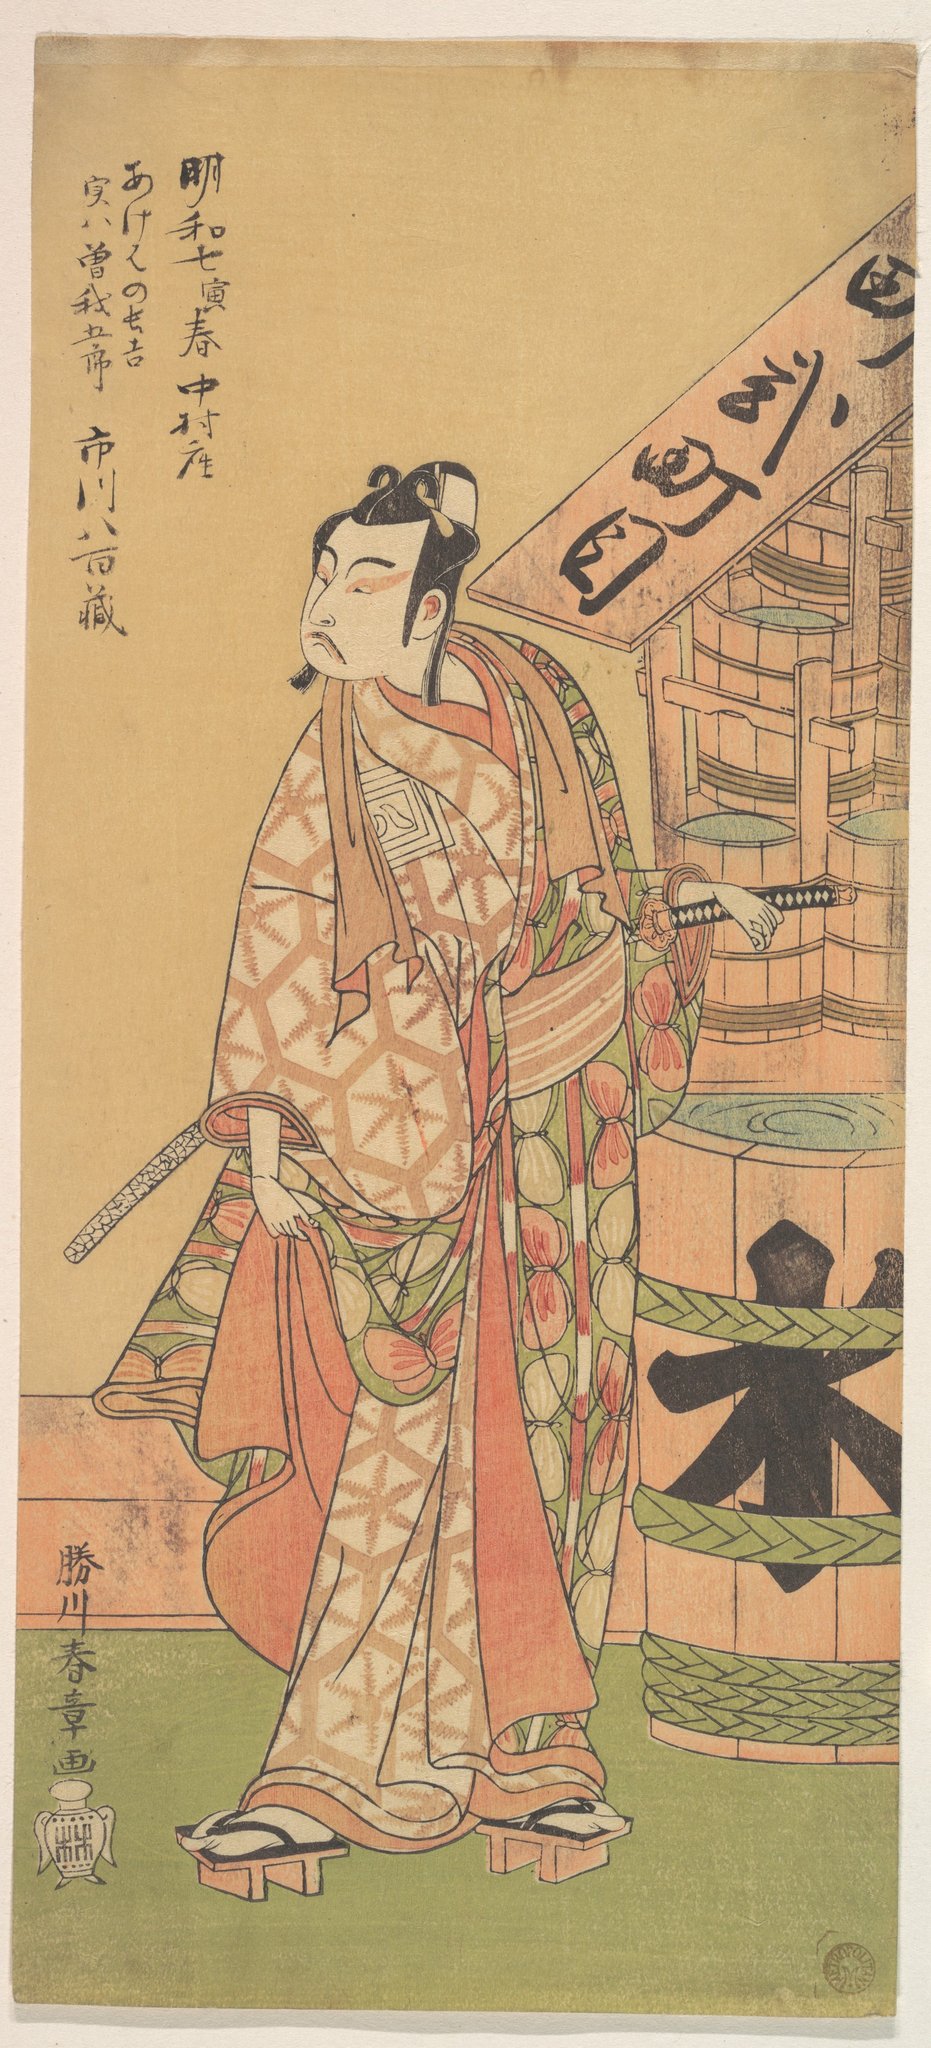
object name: woodblock print nishiki e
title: Kabuki Actor Ichikawa Yaozō II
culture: japanese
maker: katsukawa shunshō 勝川春章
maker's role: artist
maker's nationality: japanese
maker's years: 1726-1792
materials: ink, paper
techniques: nishiki e, woodblock print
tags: theatre,men,actors